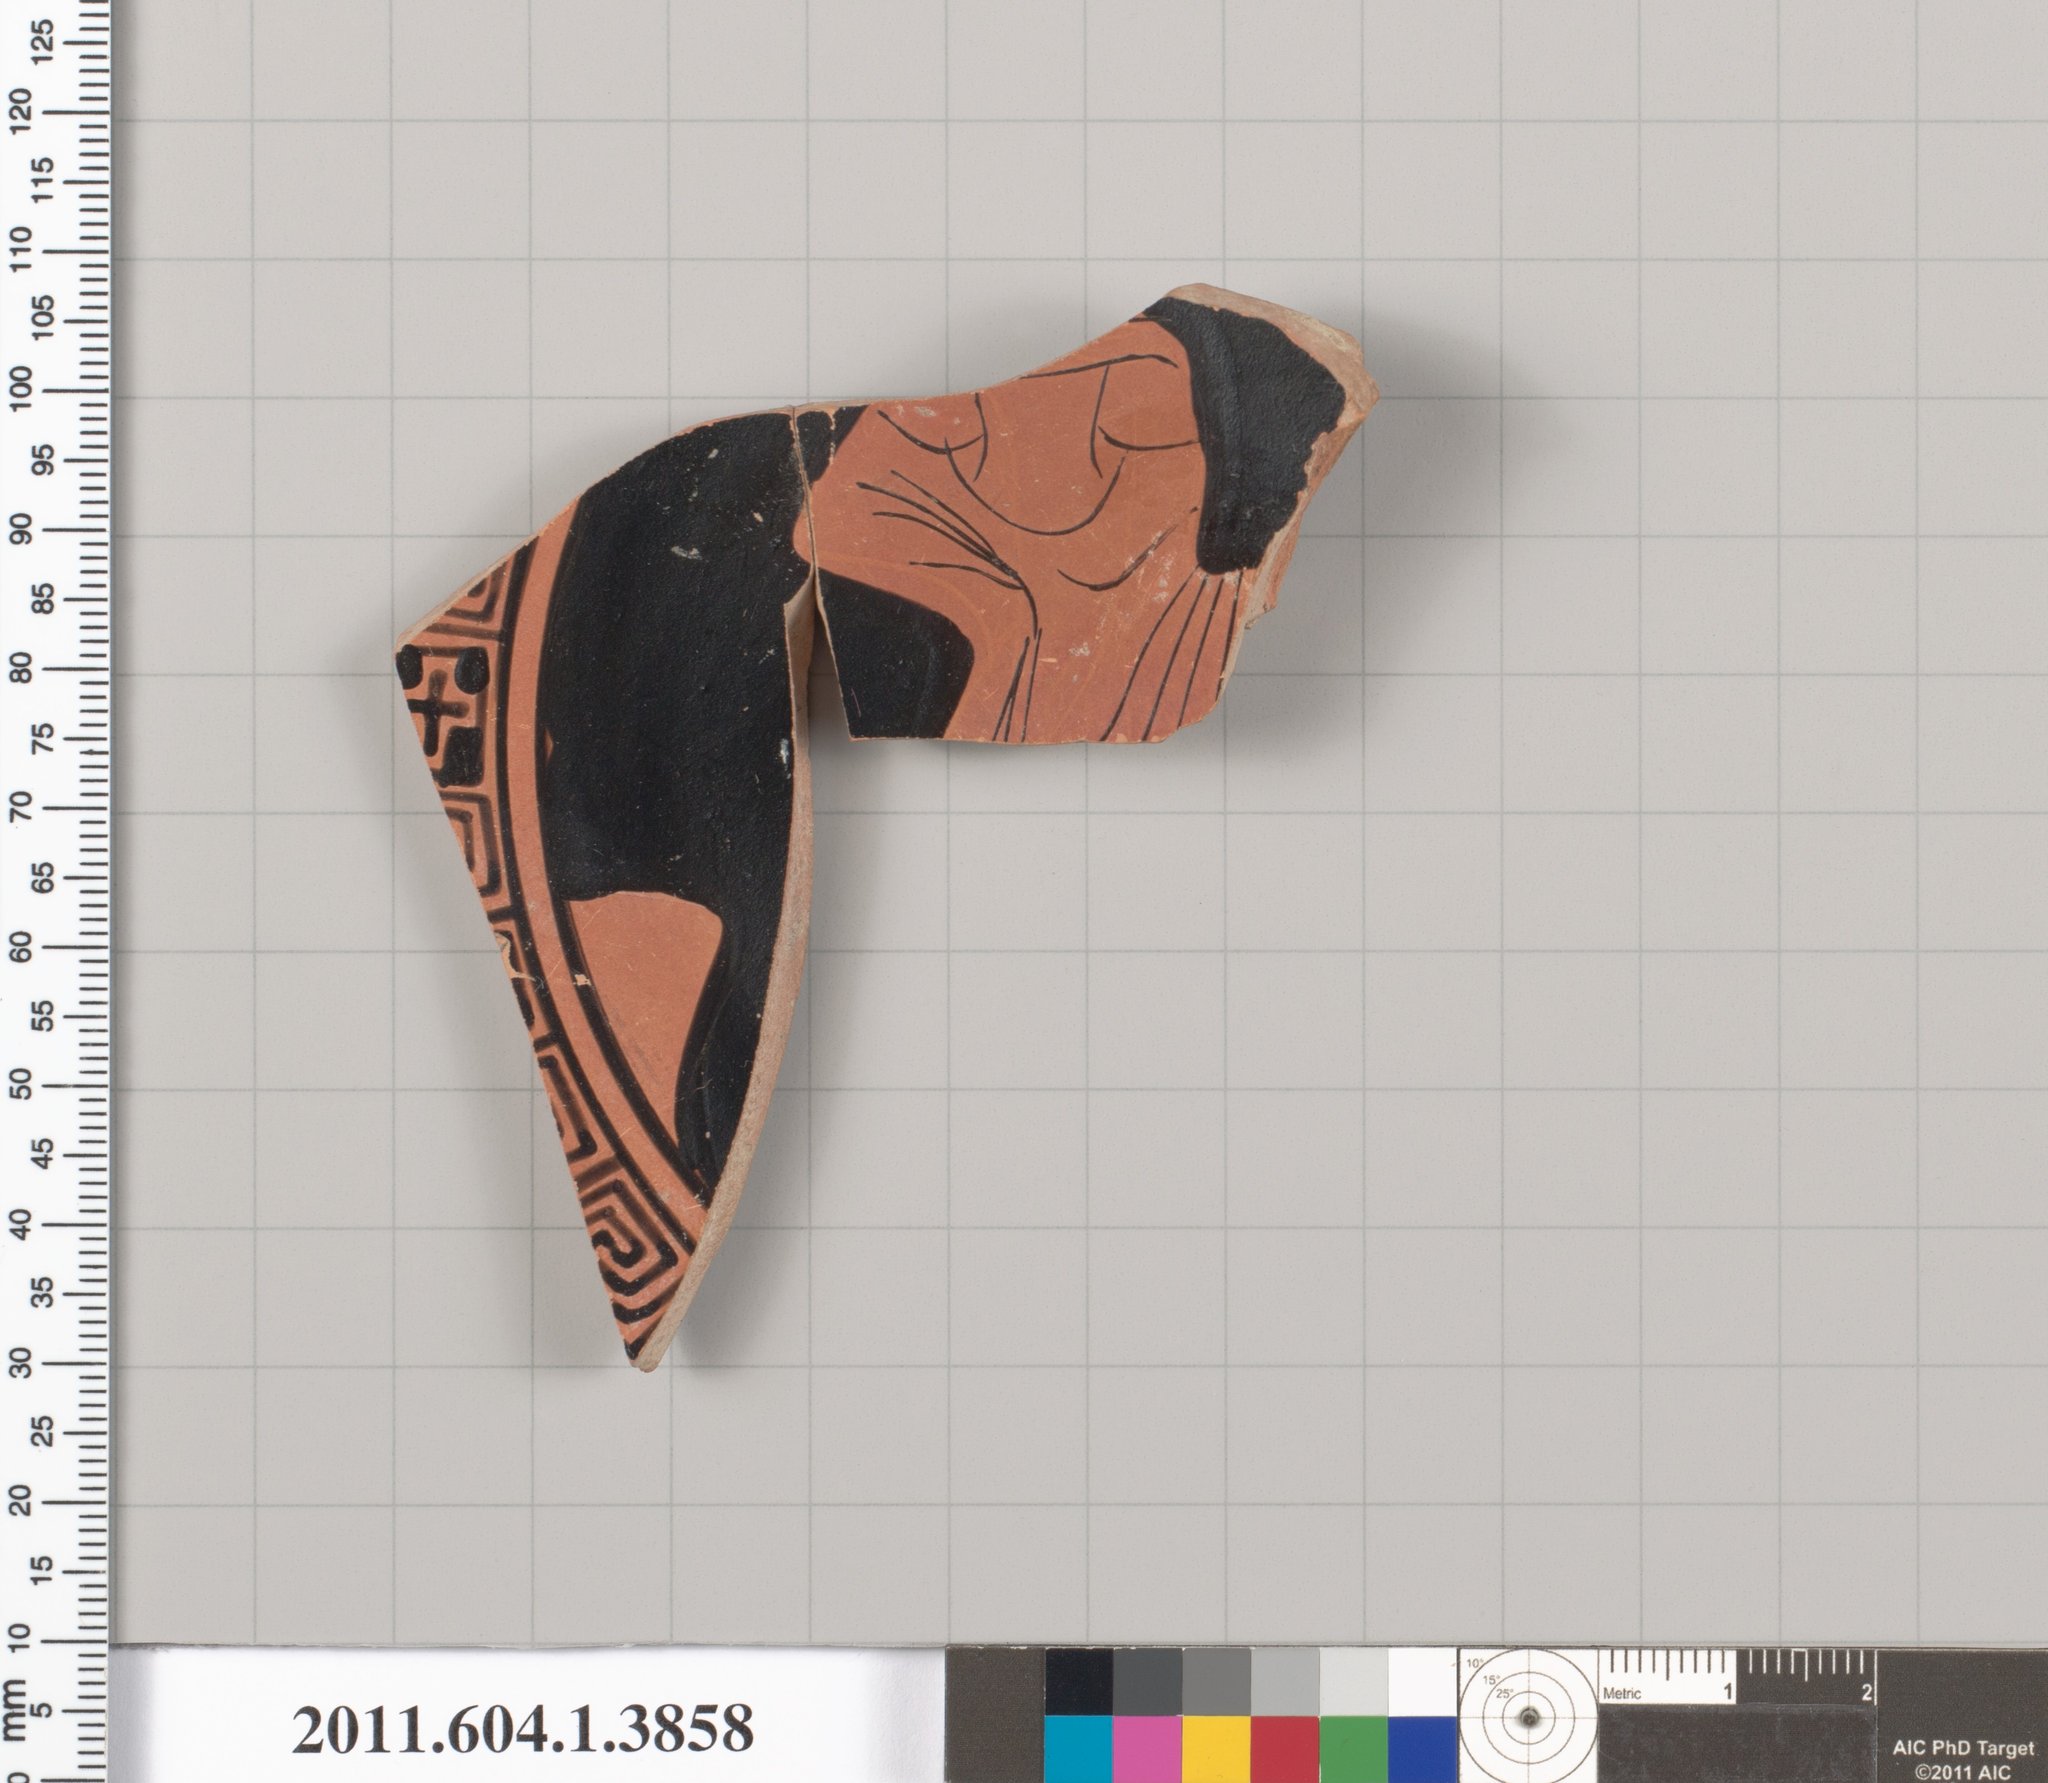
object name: kylix fragment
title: Terracotta fragment of a kylix (drinking cup)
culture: greek, attic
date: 460-450 BCE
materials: terracotta